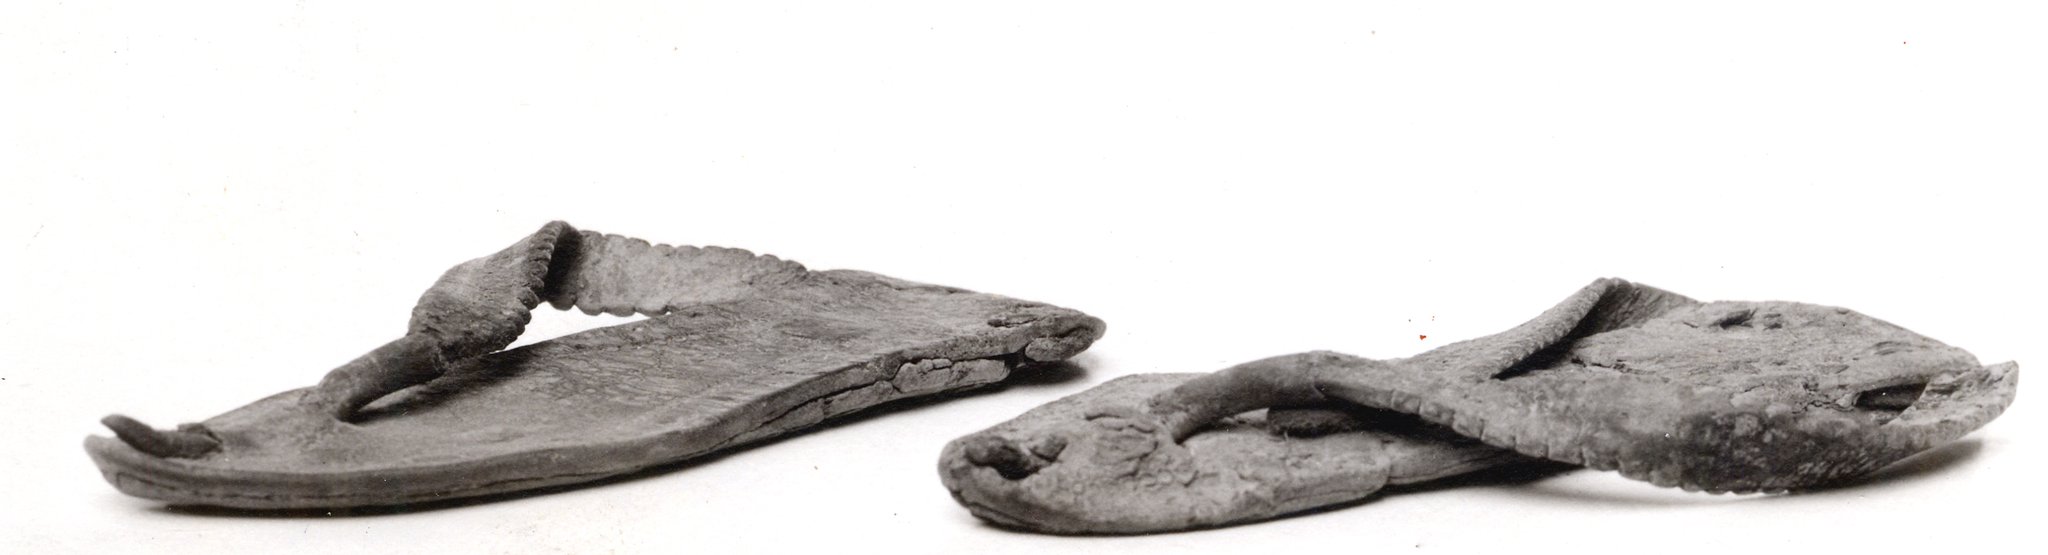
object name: sandal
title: Pair of Child's Sandals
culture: coptic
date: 301-400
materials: leather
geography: egypt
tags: footwear